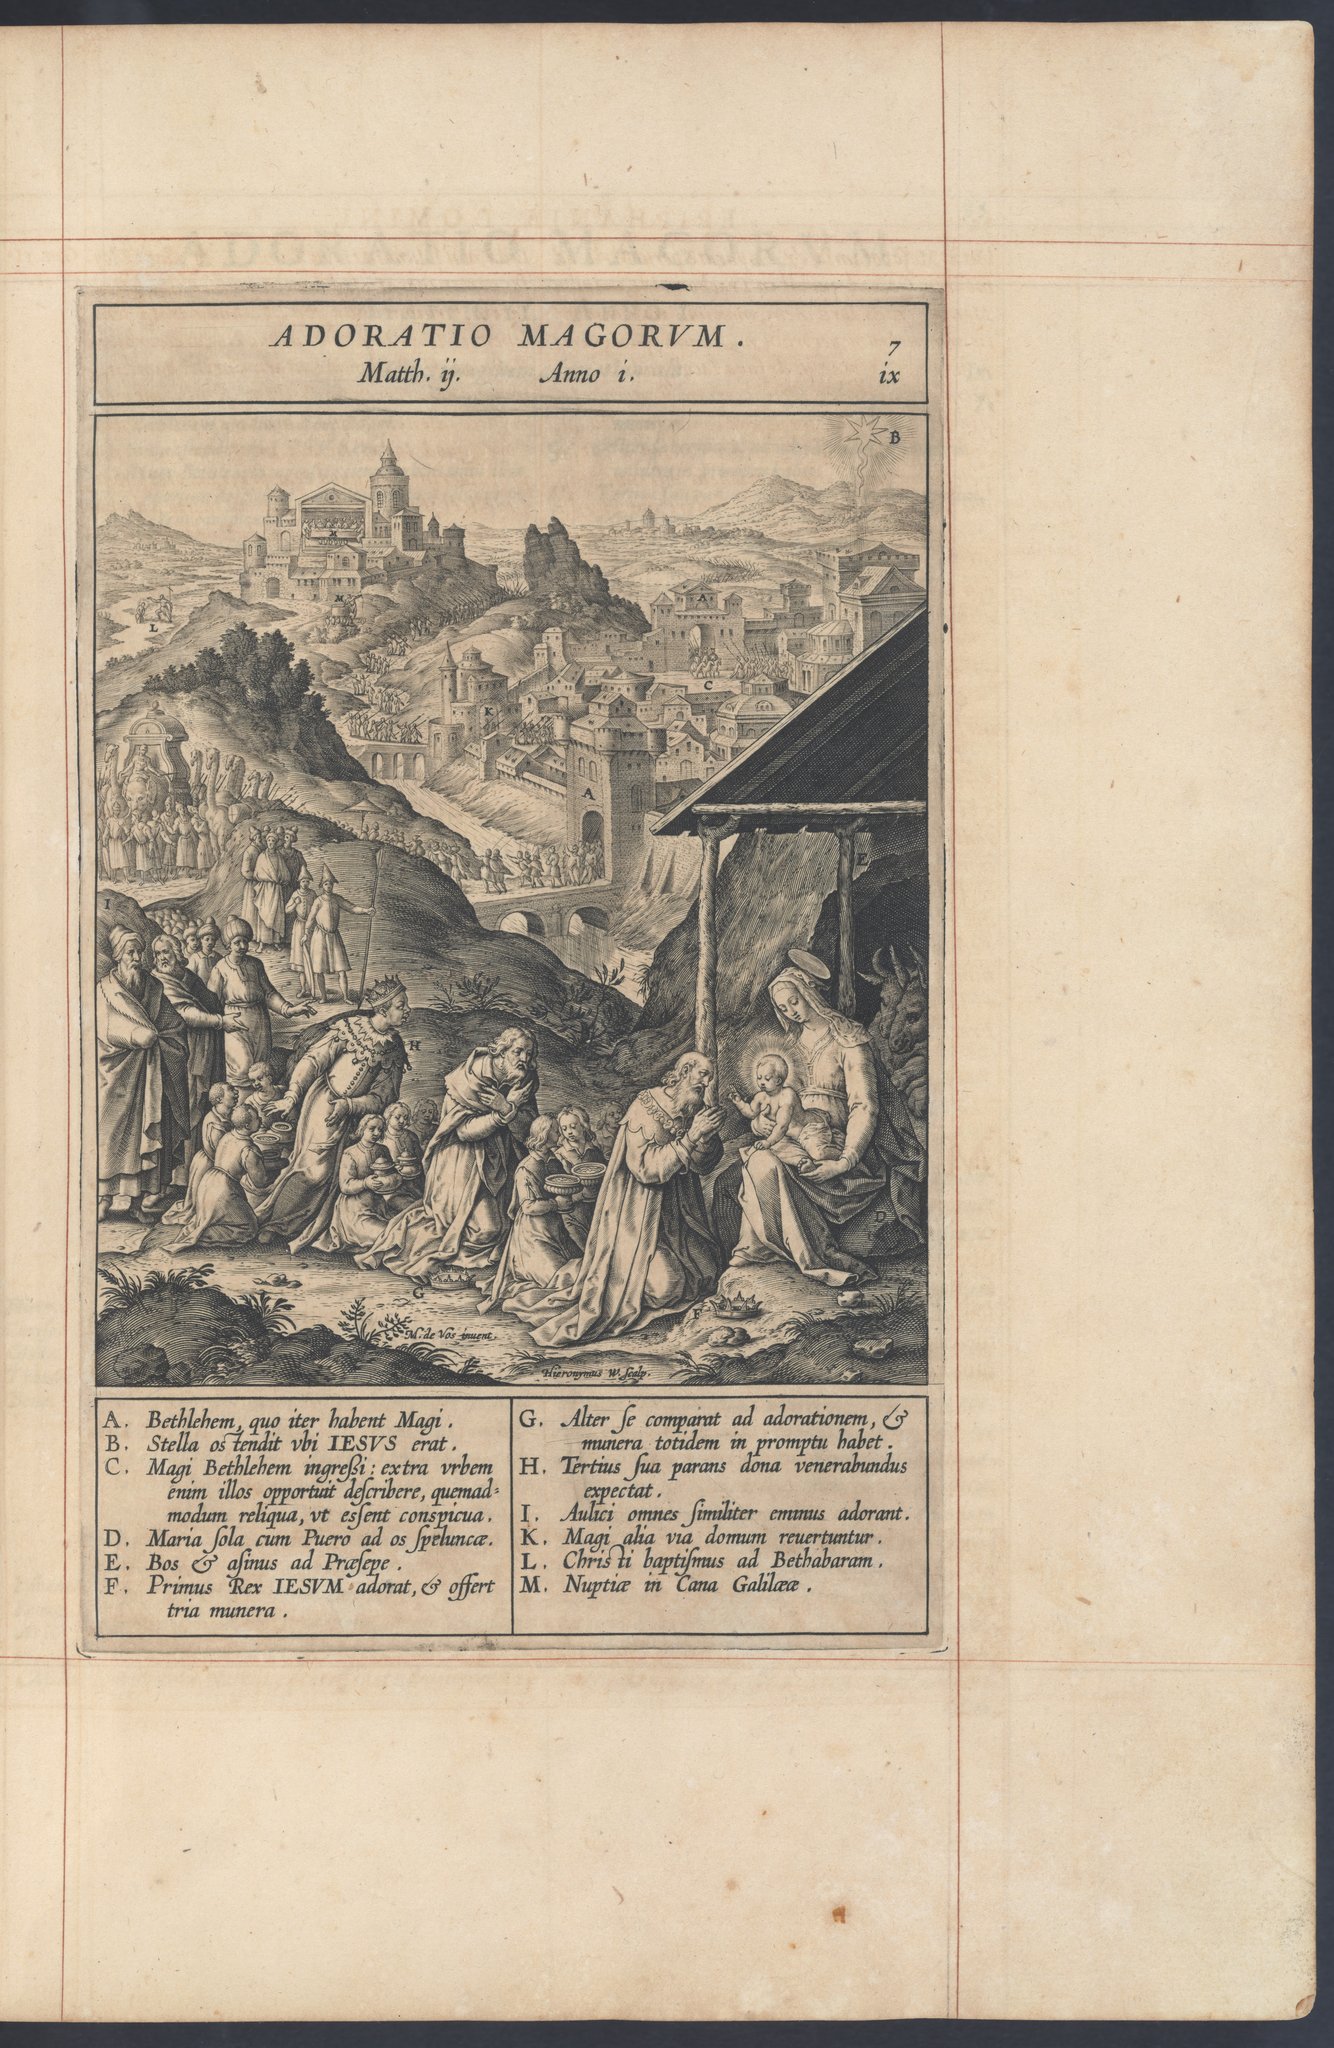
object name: book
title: Adnotationes et Meditationes in Evangelia...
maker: hieronymus natalis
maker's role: author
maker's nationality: netherlandish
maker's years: 16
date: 1595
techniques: engraving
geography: antwerp